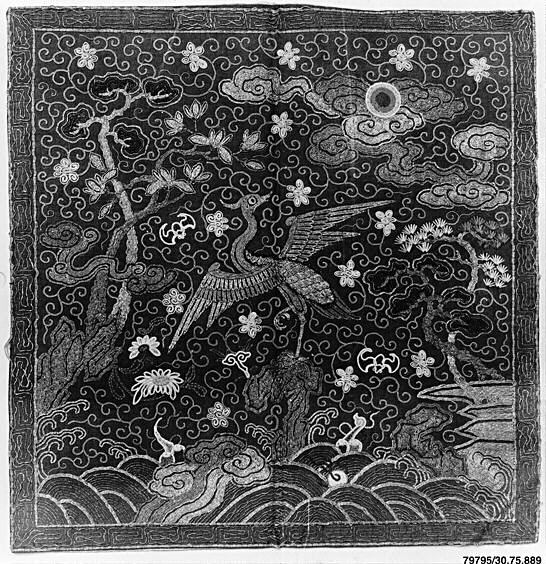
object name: rank badge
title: Rank Badge with Mandarin Duck (?)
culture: chinese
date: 1767-1800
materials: metal thread, silk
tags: ducks